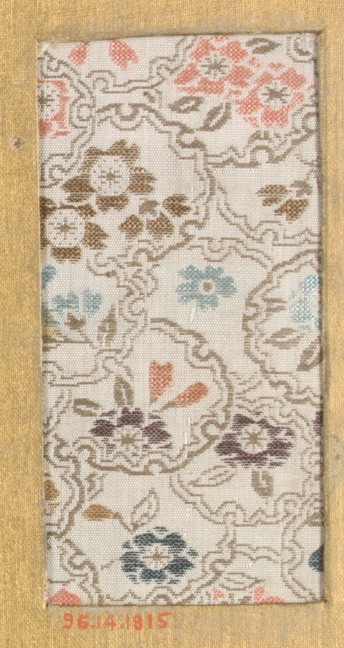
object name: piece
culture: japanese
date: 1701-1900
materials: silk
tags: flowers